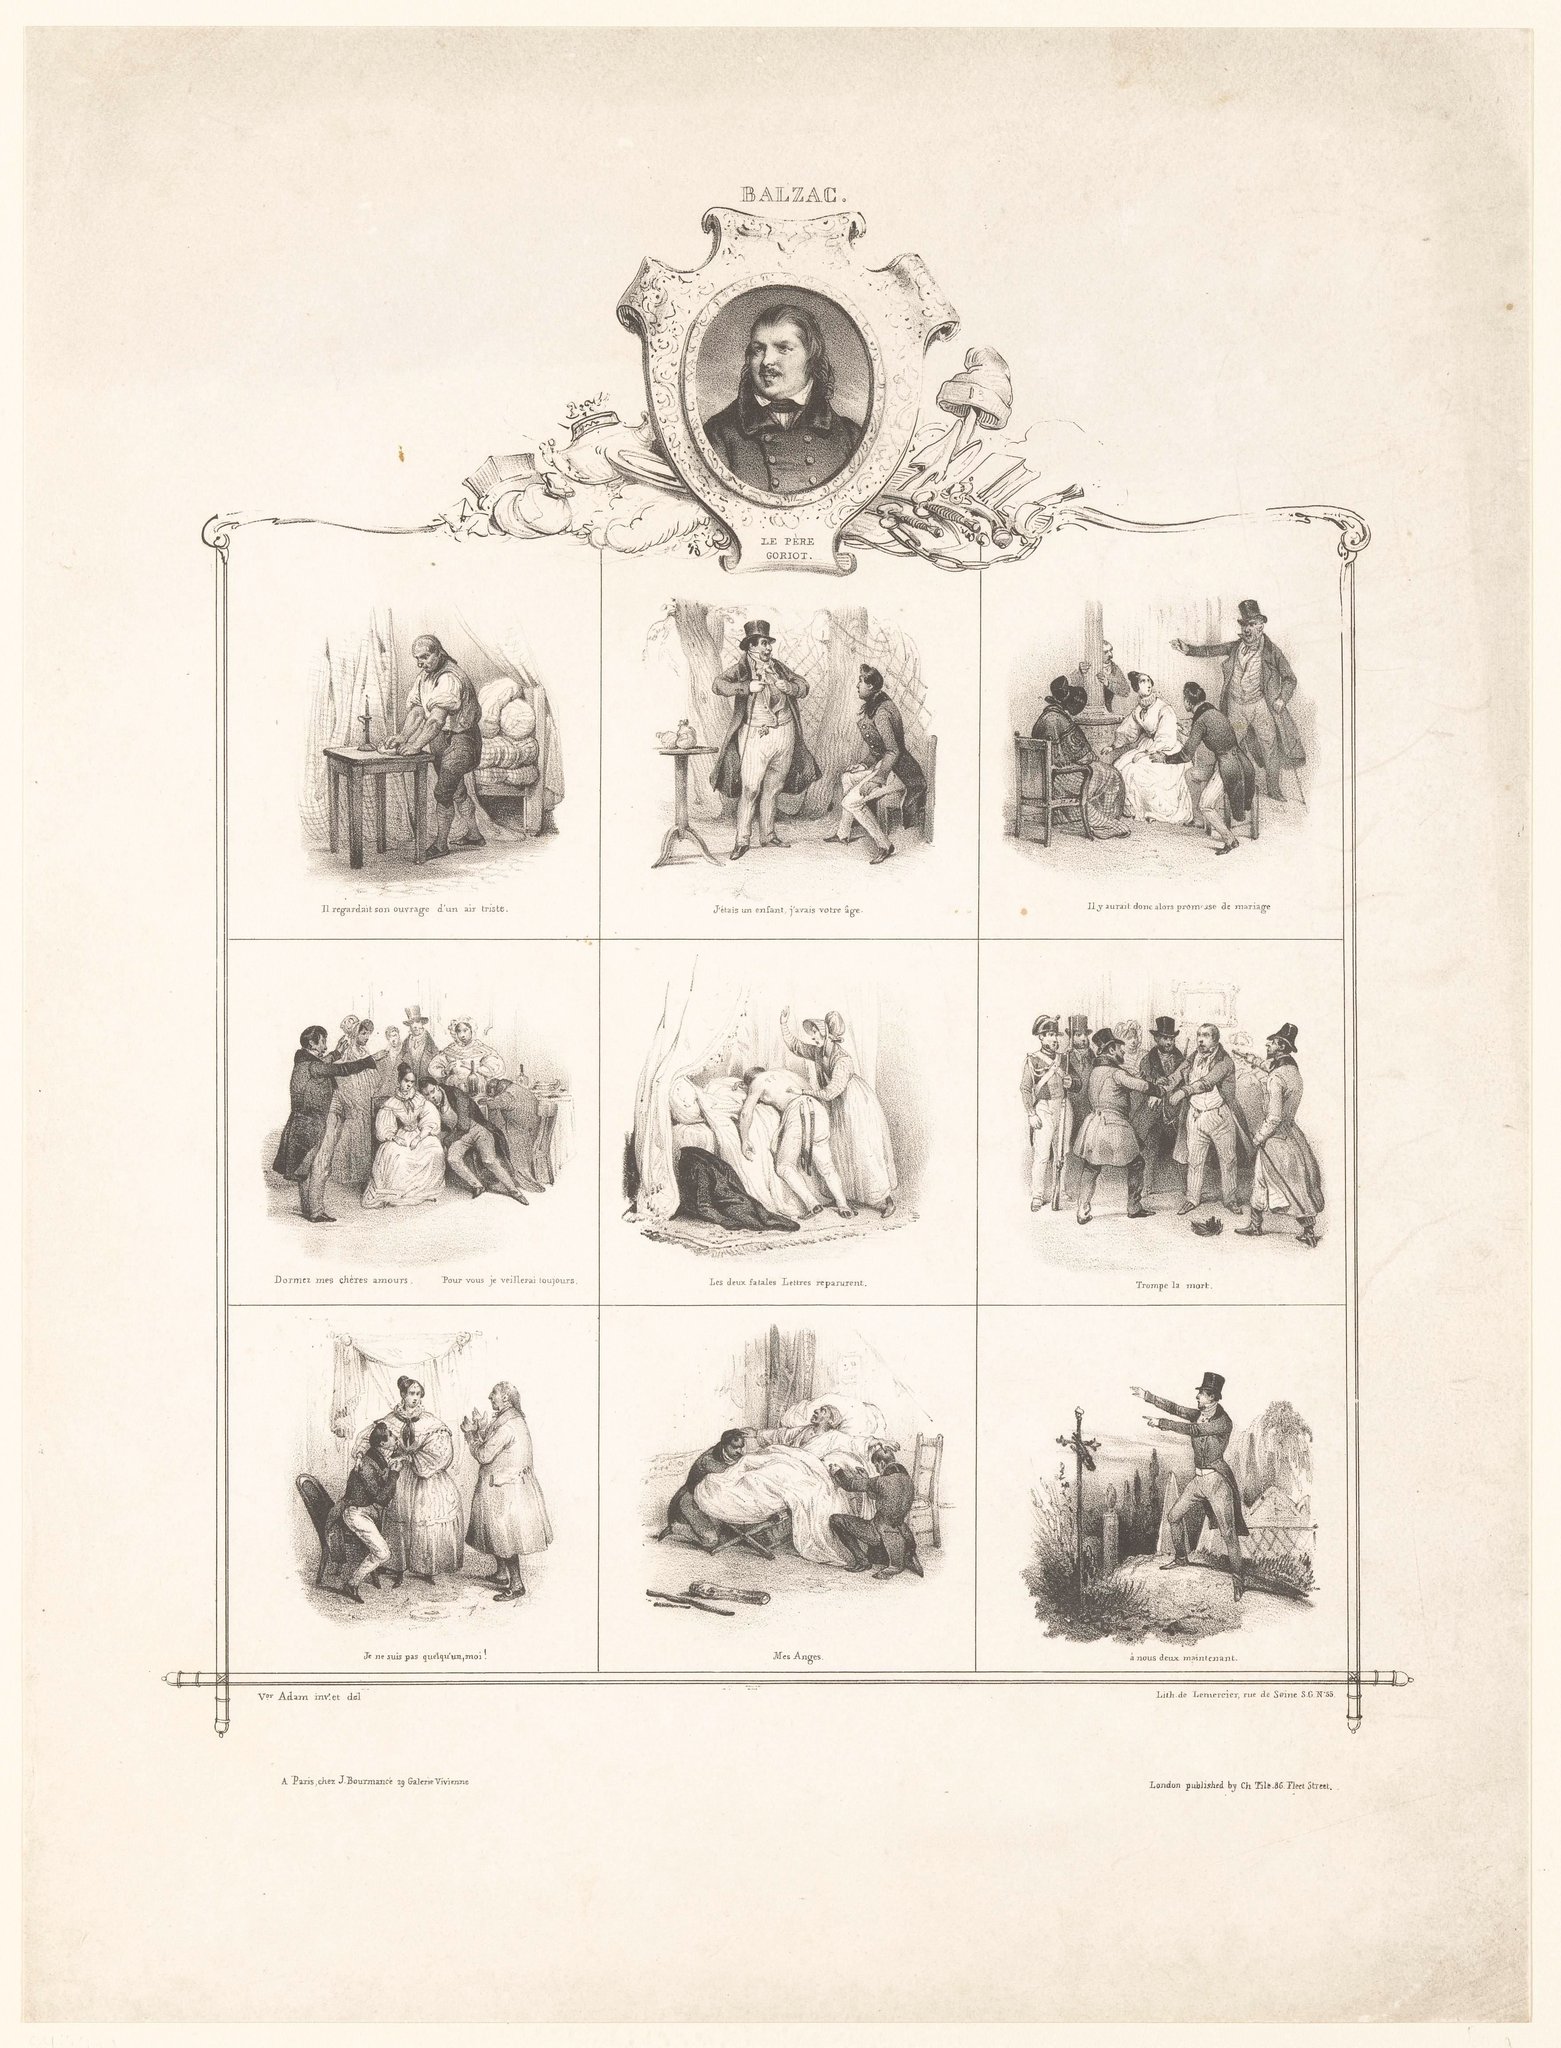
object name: print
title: Balzac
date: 1834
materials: paper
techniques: lithograph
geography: paris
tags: paris, honoré de balzac, historical persons, portrait of a writer, (scenes from) specific works of literature (with author, title)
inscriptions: collector's mark: Lugt 2228